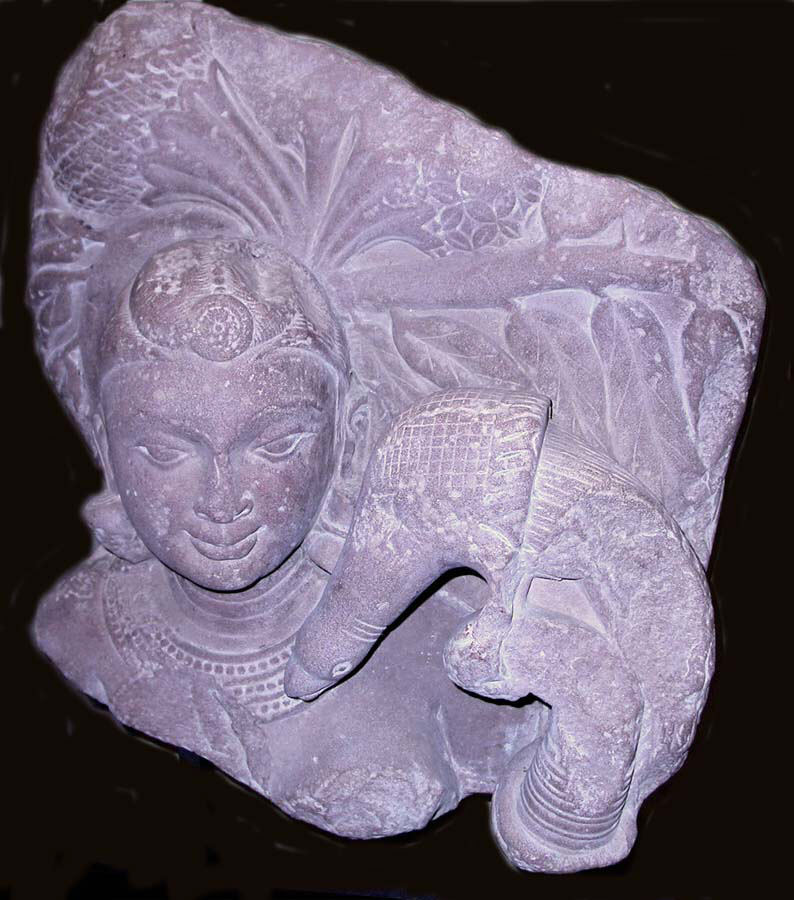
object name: relief fragment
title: Woman with a Parrot (Study Collection)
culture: indian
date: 1901-2000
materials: stone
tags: women,parrots